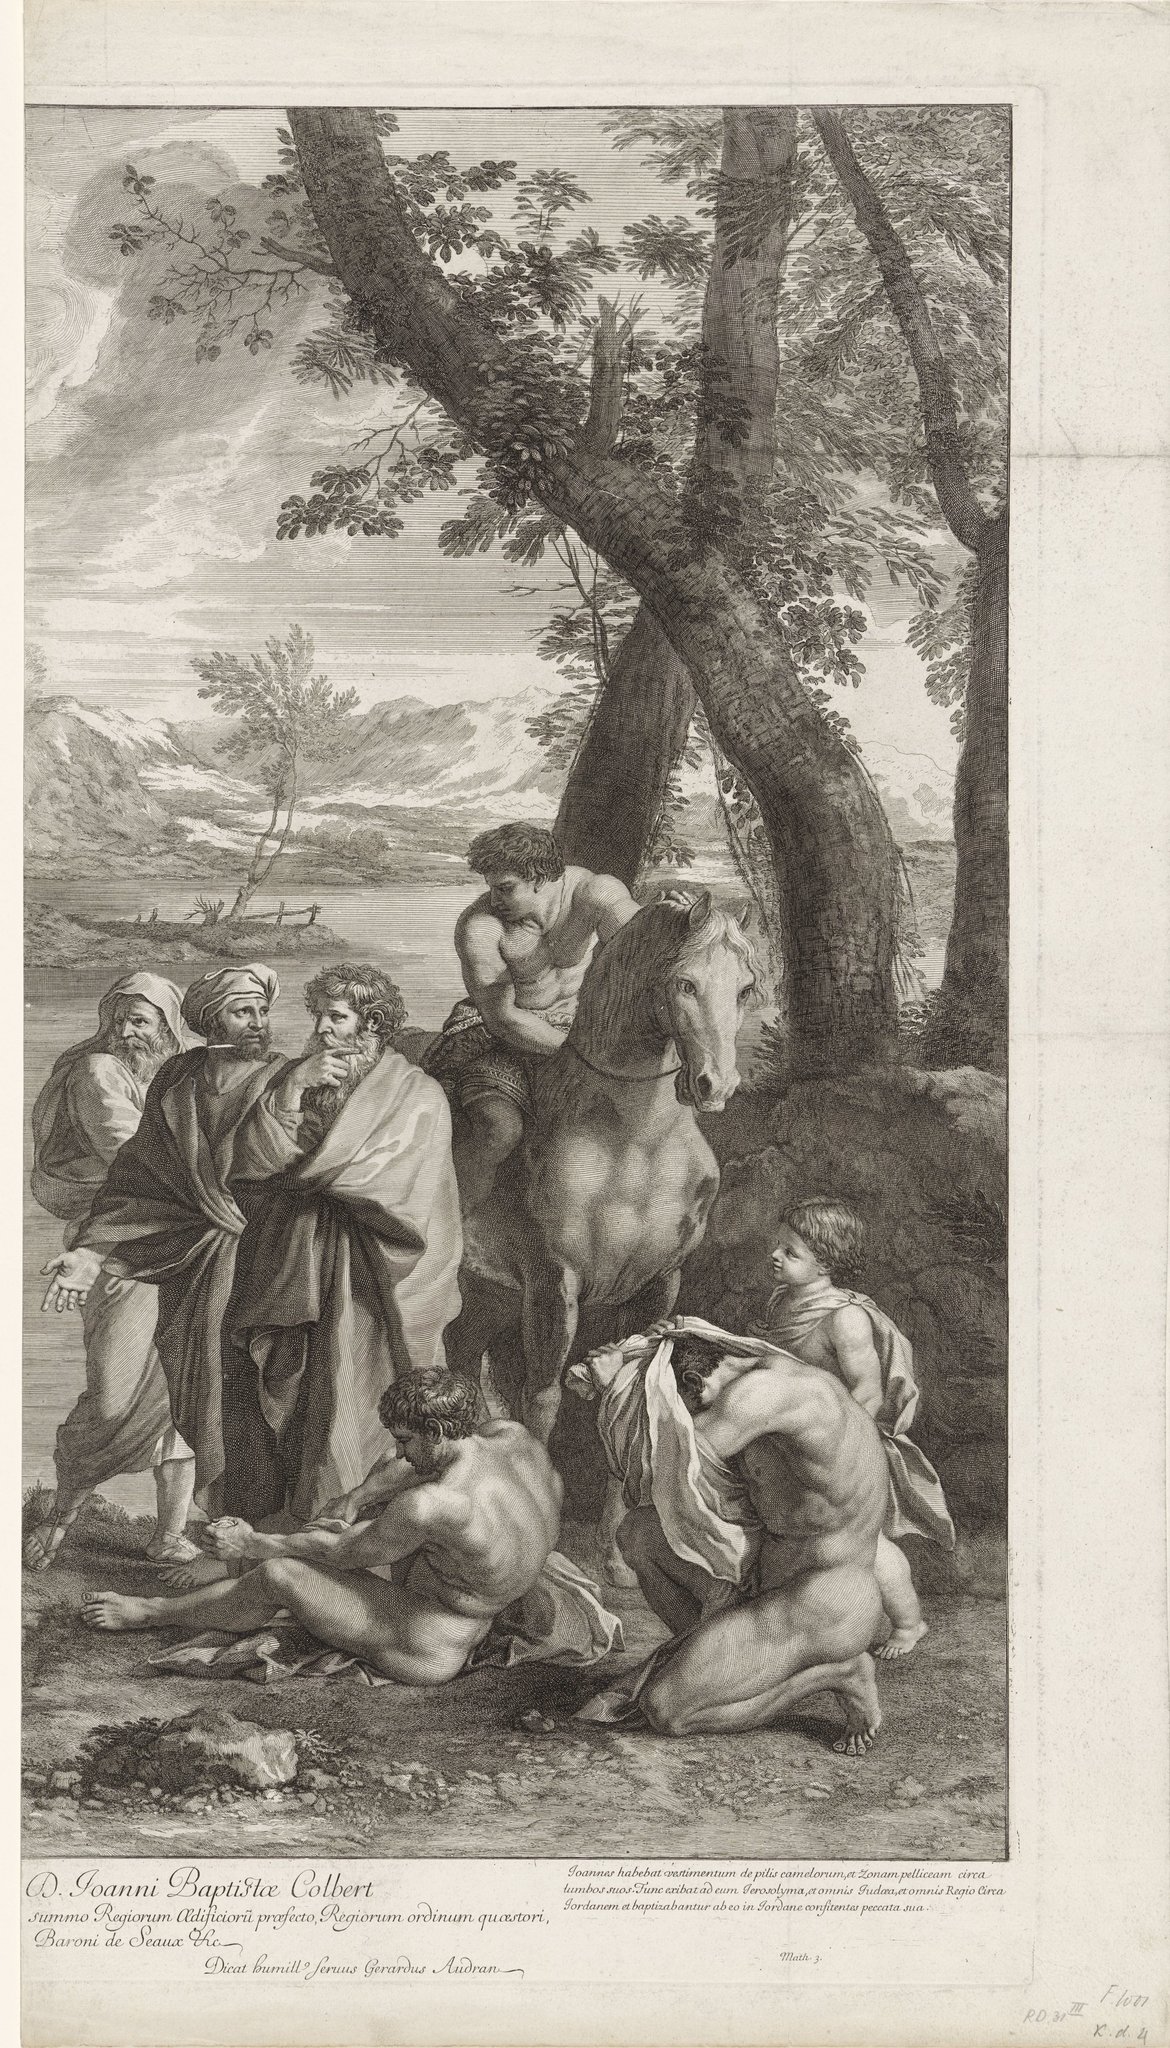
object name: print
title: Johannes de Doper doopt de Farizeeërs (rechter deel)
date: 1650-1703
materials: paper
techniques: engraving, etching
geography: france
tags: john the baptist baptizing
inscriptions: inscription: ‘F1001’, collector's mark: Lugt 240, inscription: ‘K.d. 4’, collector's mark: Lugt 1838, inscription: ‘RD31III’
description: Rechterblad van een prent gedrukt van twee platen.